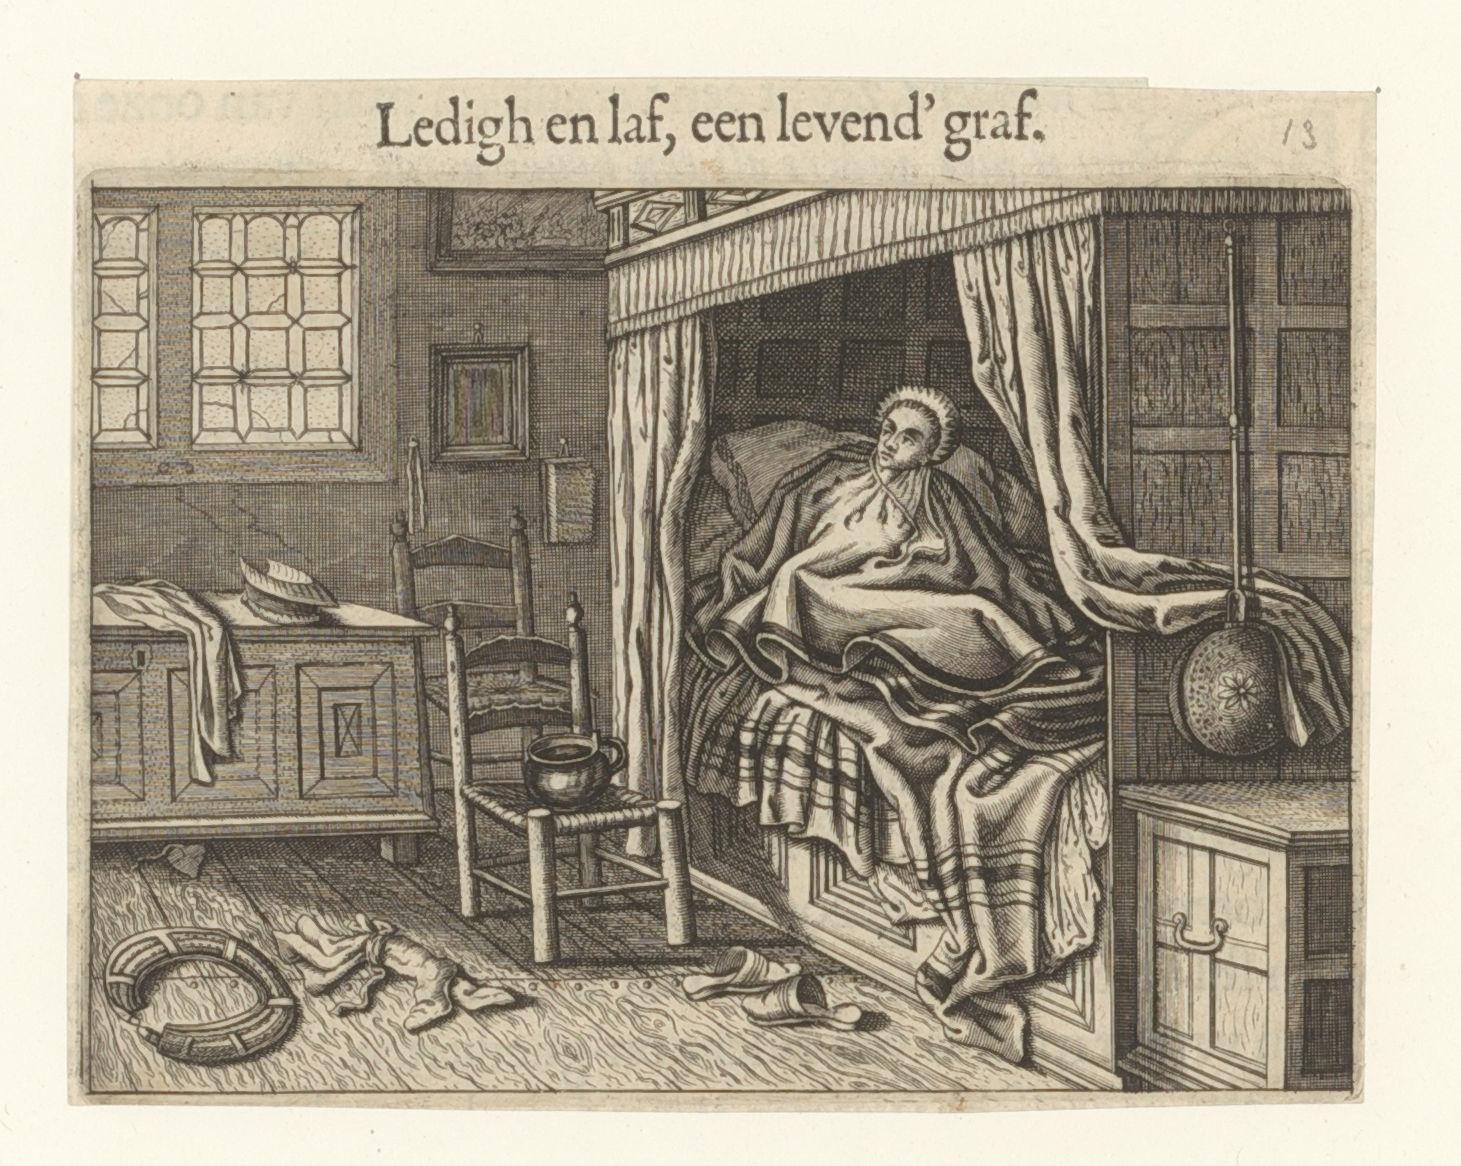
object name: print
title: Ledigh en laf, een levend' graf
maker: Anonymous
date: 1624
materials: paper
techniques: engraving, letterpress printing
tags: adult woman, single woman, spinster, bed with tester, proverbs, sayings, etc., bedroom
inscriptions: collector's mark: Lugt 1641, stamp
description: Embleem uit: Brune, Johan de. Zinne-werck, Voor-ghesyelt in Beelden, Ghedichten, ende breeder uyt-legginghen (...). Amsterdam: Evertsen Kloppenburch, 1624. Prent ook gebruikt in latere edities (1636 en 1661).